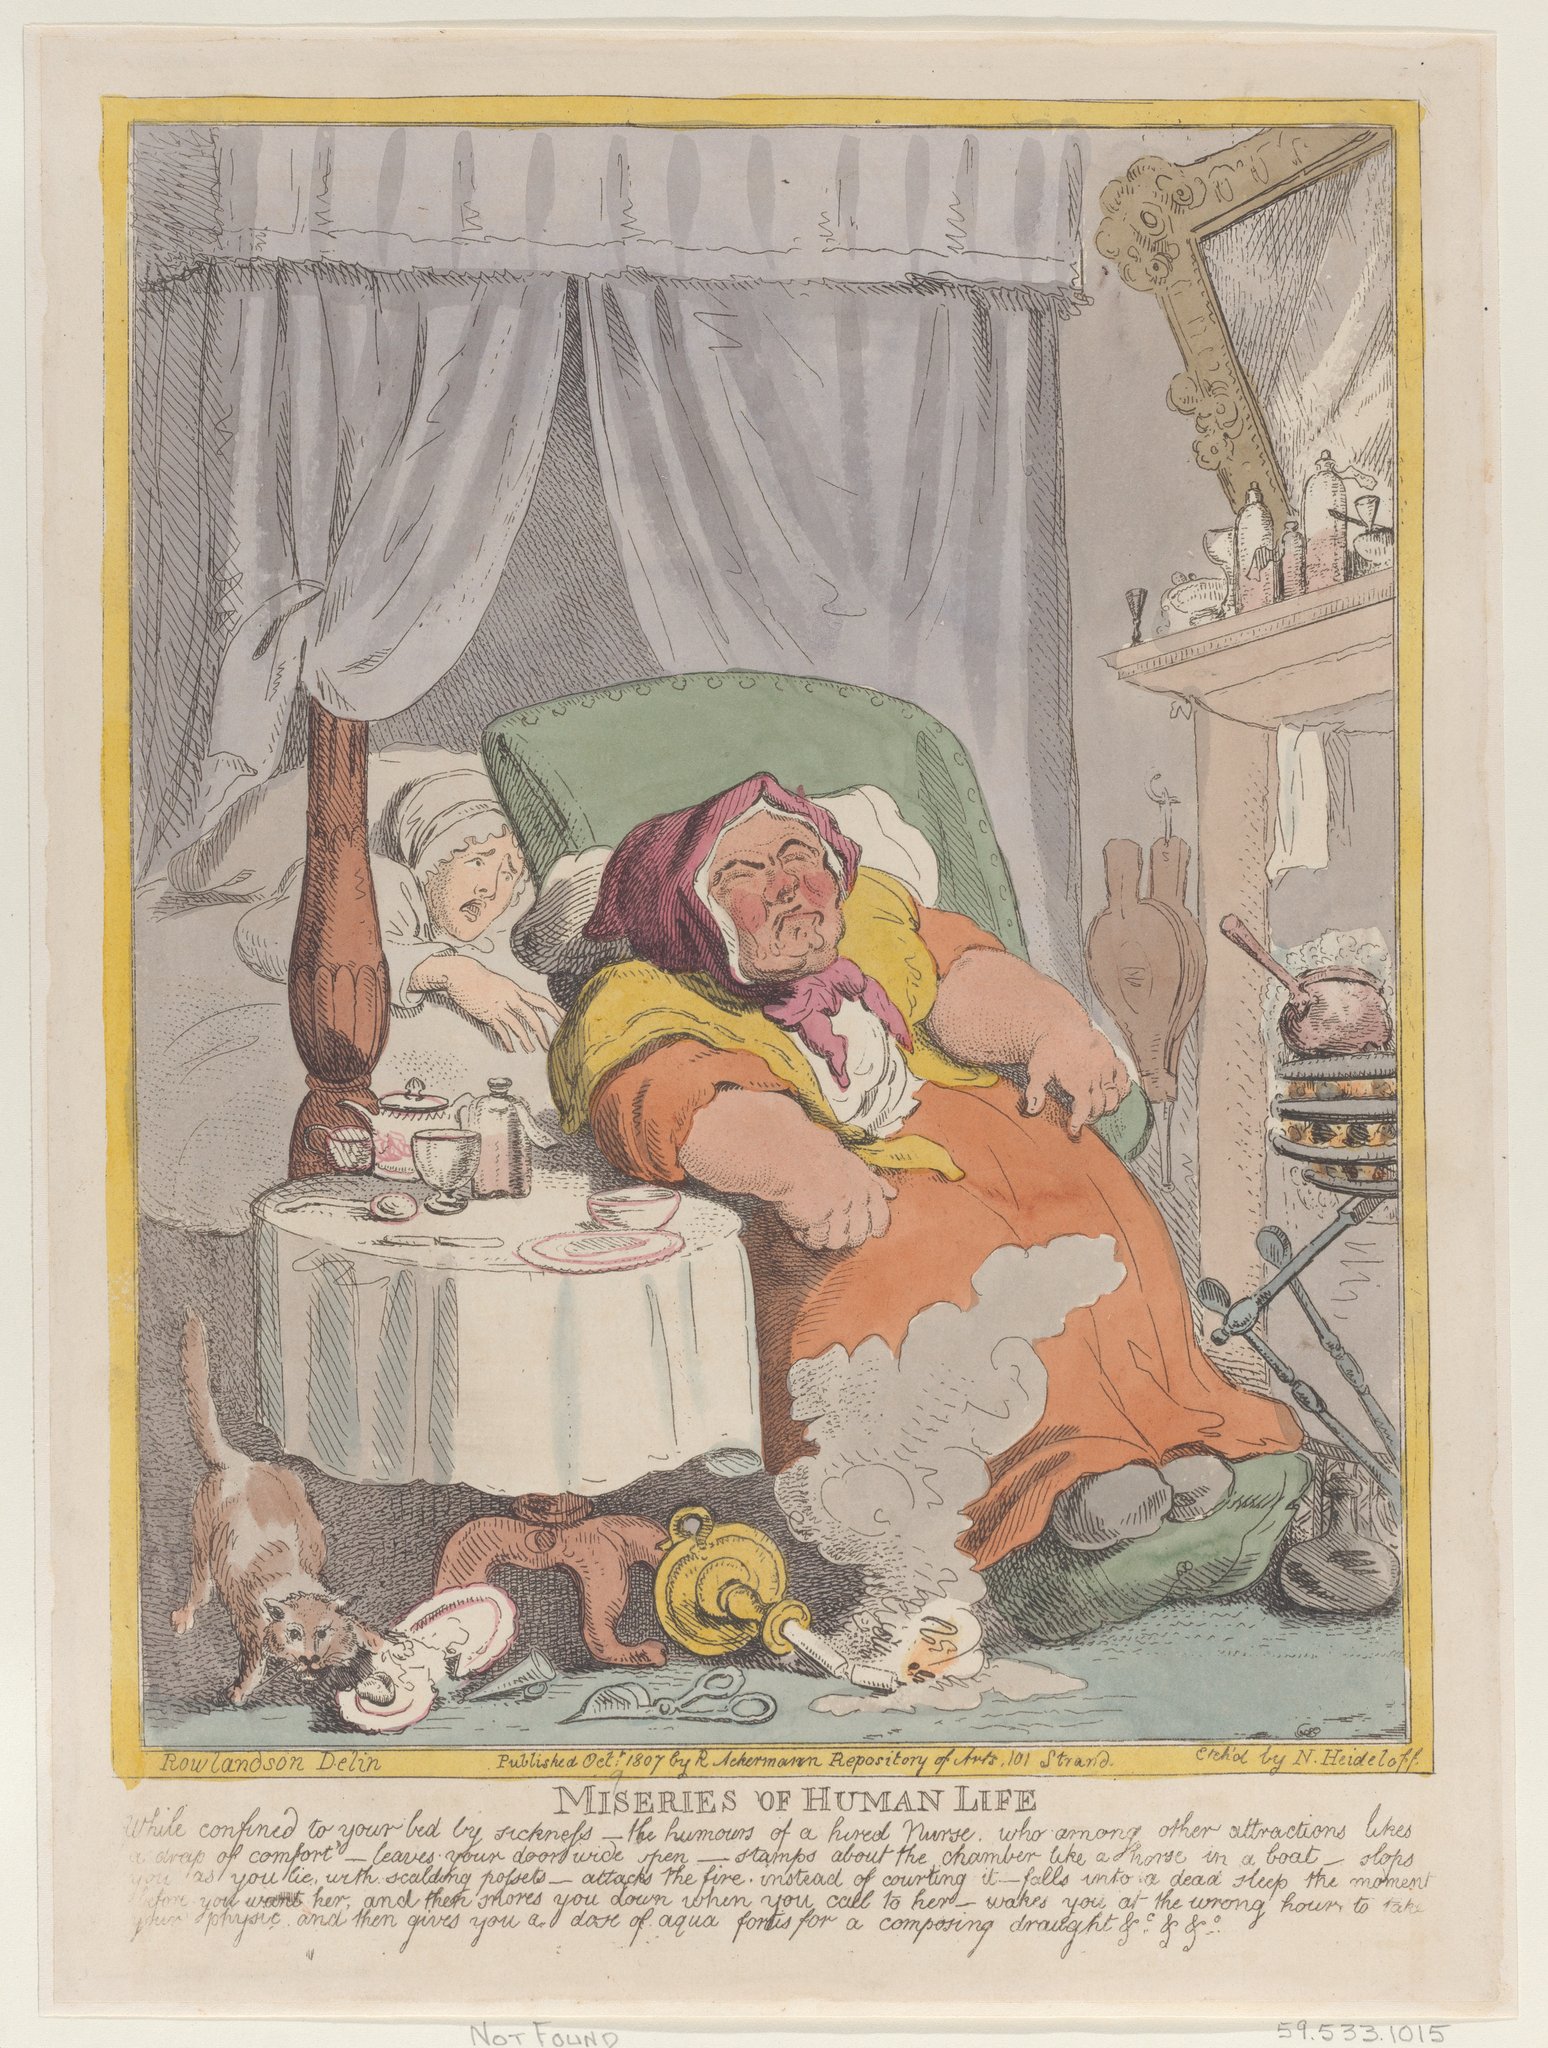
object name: print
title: Miseries of Human Life: "While confined to your bed by sickness..."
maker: nicolaus heideloff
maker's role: publisher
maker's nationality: british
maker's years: 1761-1837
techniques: etching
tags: satire,bedrooms,illness,women,cats